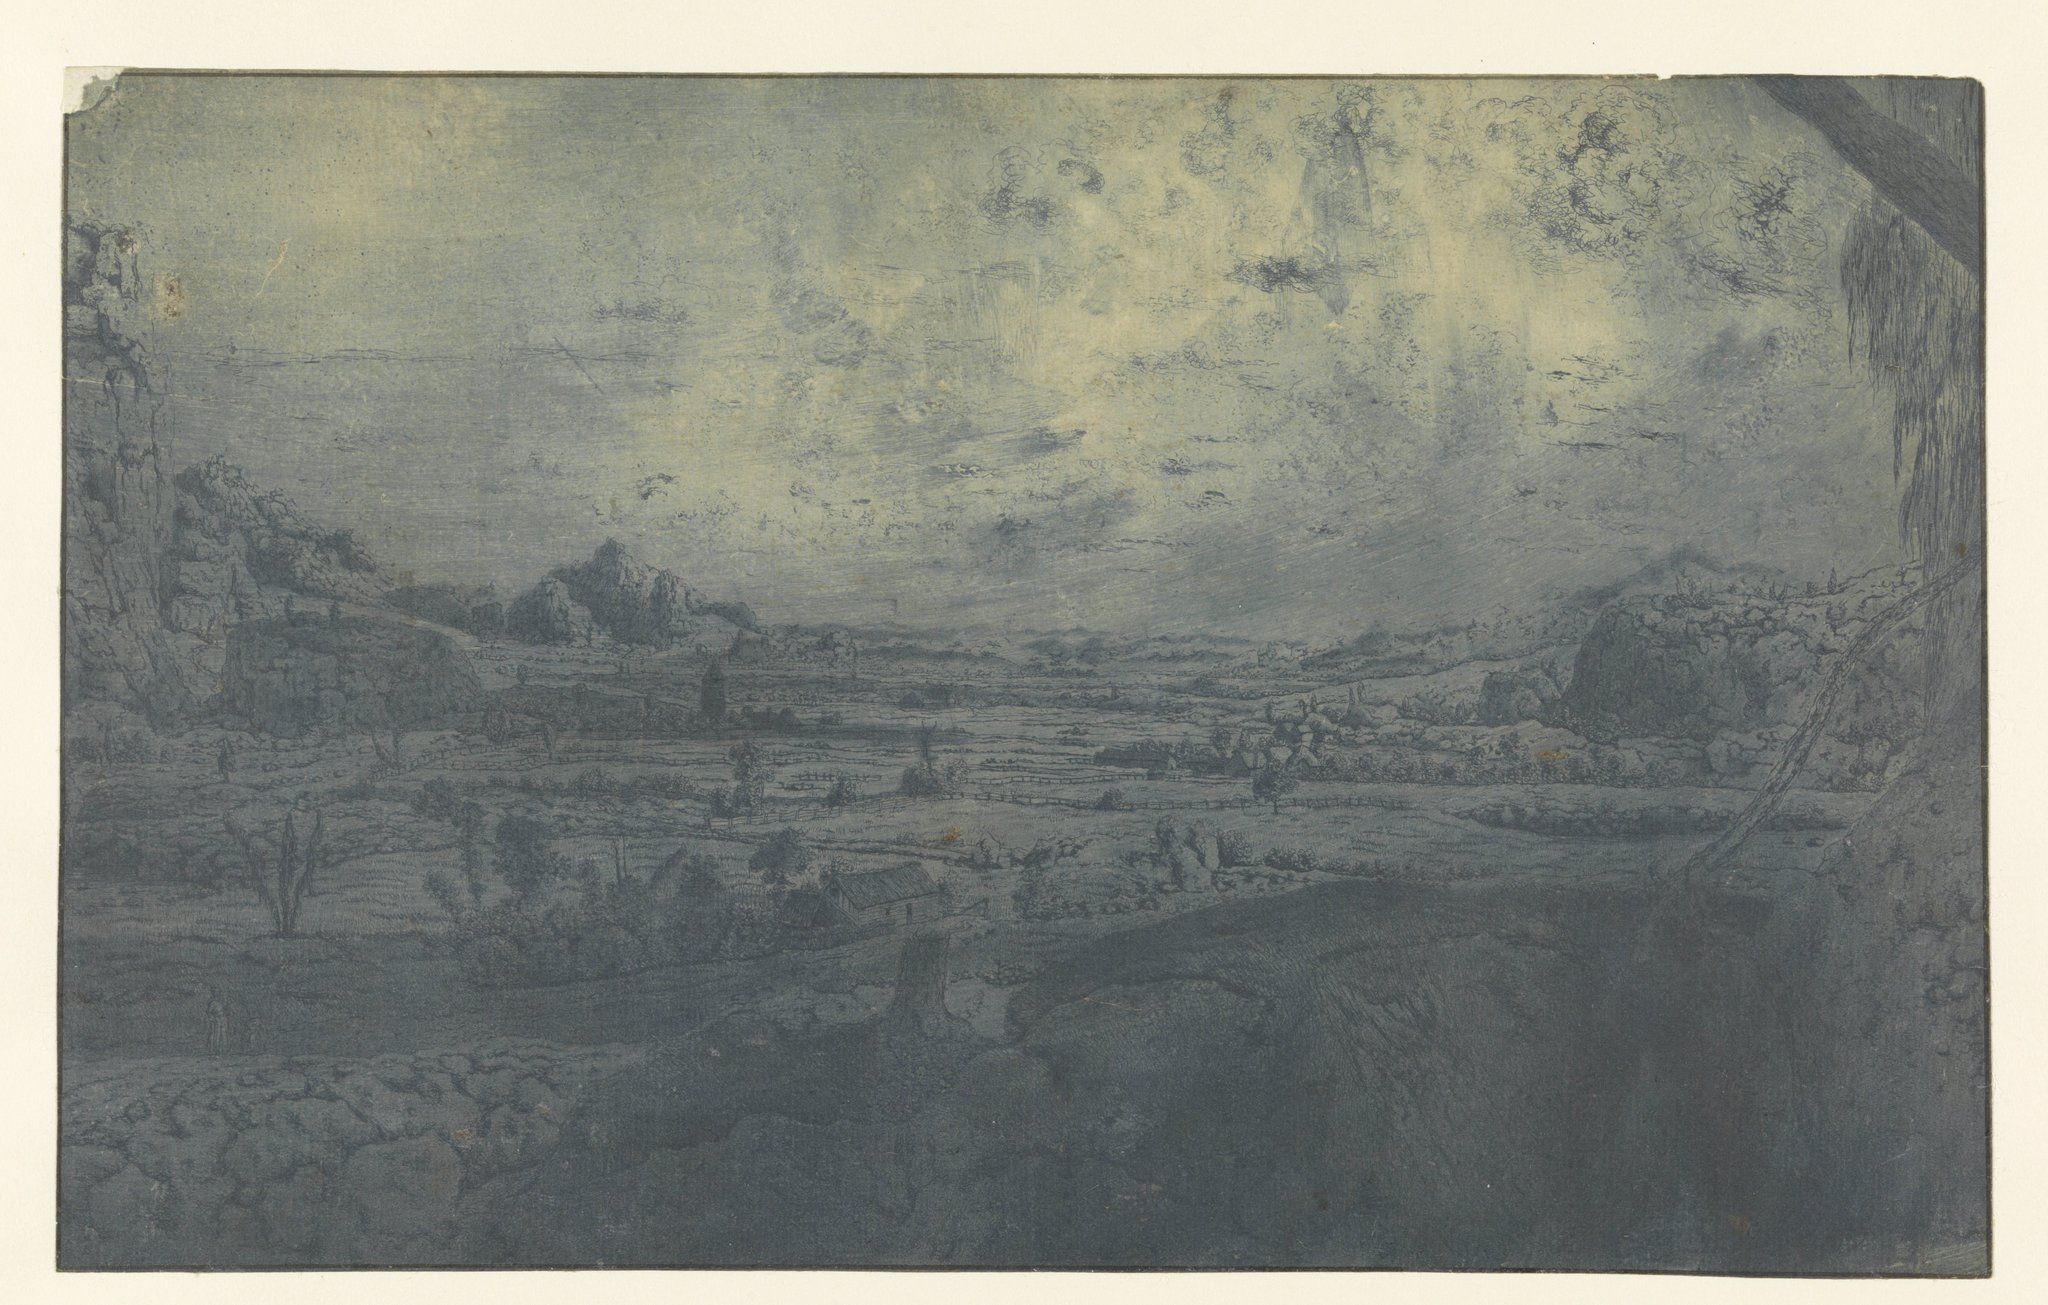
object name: print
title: Mountain Valley with Fenced Fields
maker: hercules segers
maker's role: draughtsman, painter, print maker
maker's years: 1589-1640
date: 1625-1630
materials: paint, paper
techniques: drypoint, etching, intaglio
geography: amsterdam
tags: low hill country, balustrade, farm or solitary house in landscape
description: Segers printed this nocturnal scene with a generous amount of plate tone: he did not wipe all of the ink from the etching plate. Next he overpainted the impression with blue watercolour. The valley seems bathed in the light of an invisible moon.